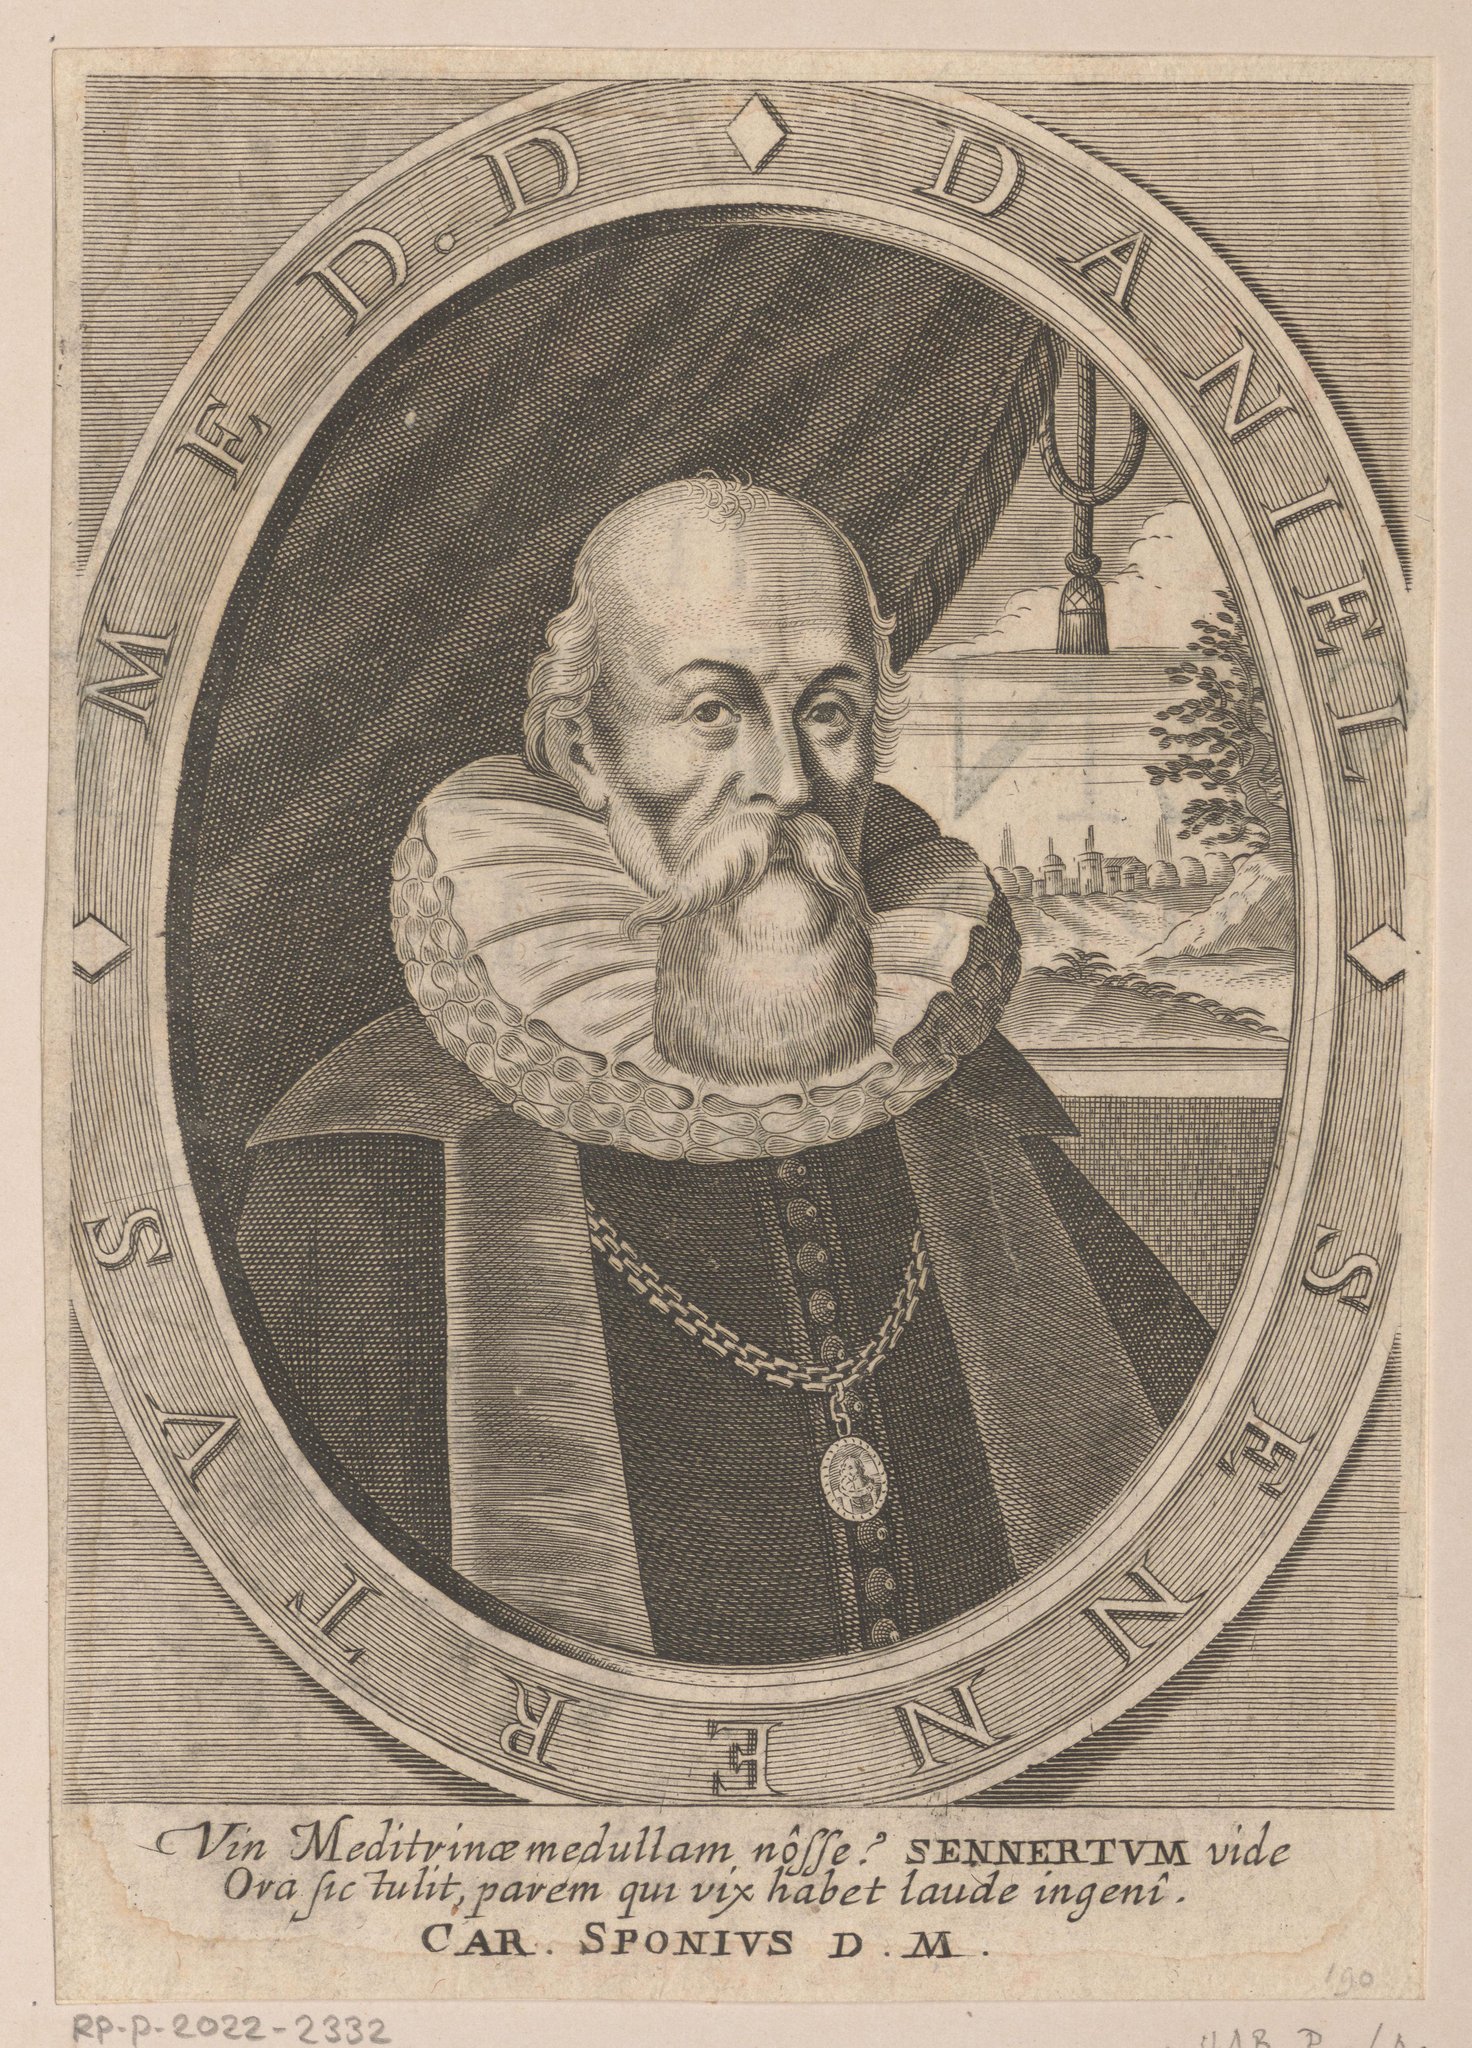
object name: print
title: Portret van Daniel Sennert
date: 1624-1699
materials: paper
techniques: engraving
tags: scholar, philosopher, historical persons, physician, doctor, professor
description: Met tweeregelig onderschrift in het Latijn.